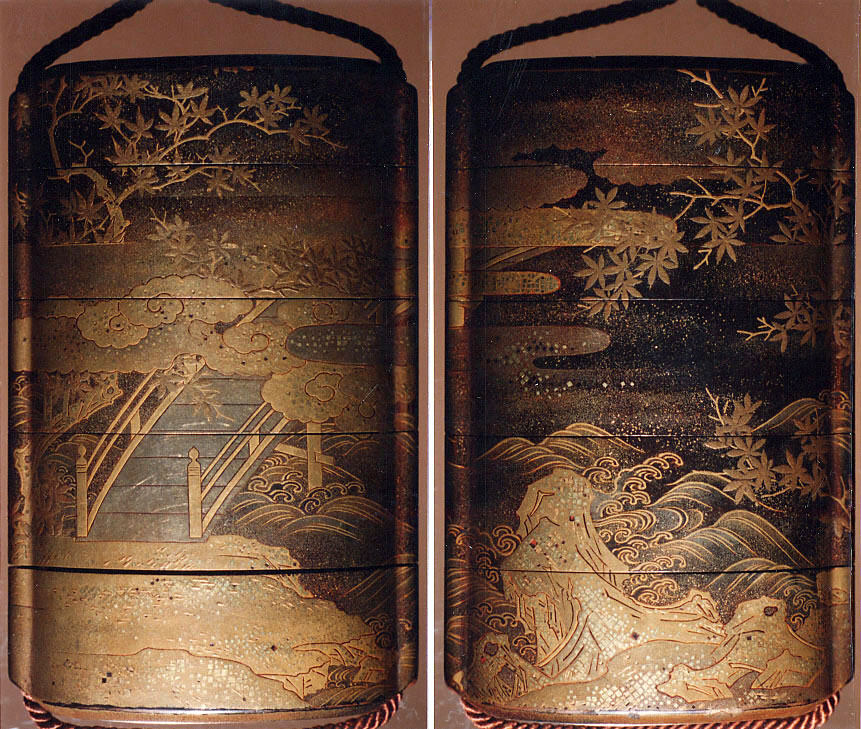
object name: inrō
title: Case (Inrō) with Design of a Diagonal Bridge Seen among Clouds and Maple Branches (obverse); Rocks and Waves beneath Maple Trees and Clouds (reverse)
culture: japanese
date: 1701-1800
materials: gold, lacquer, silver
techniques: fundame, hiramakie, roiro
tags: bridges,trees,waves,clouds